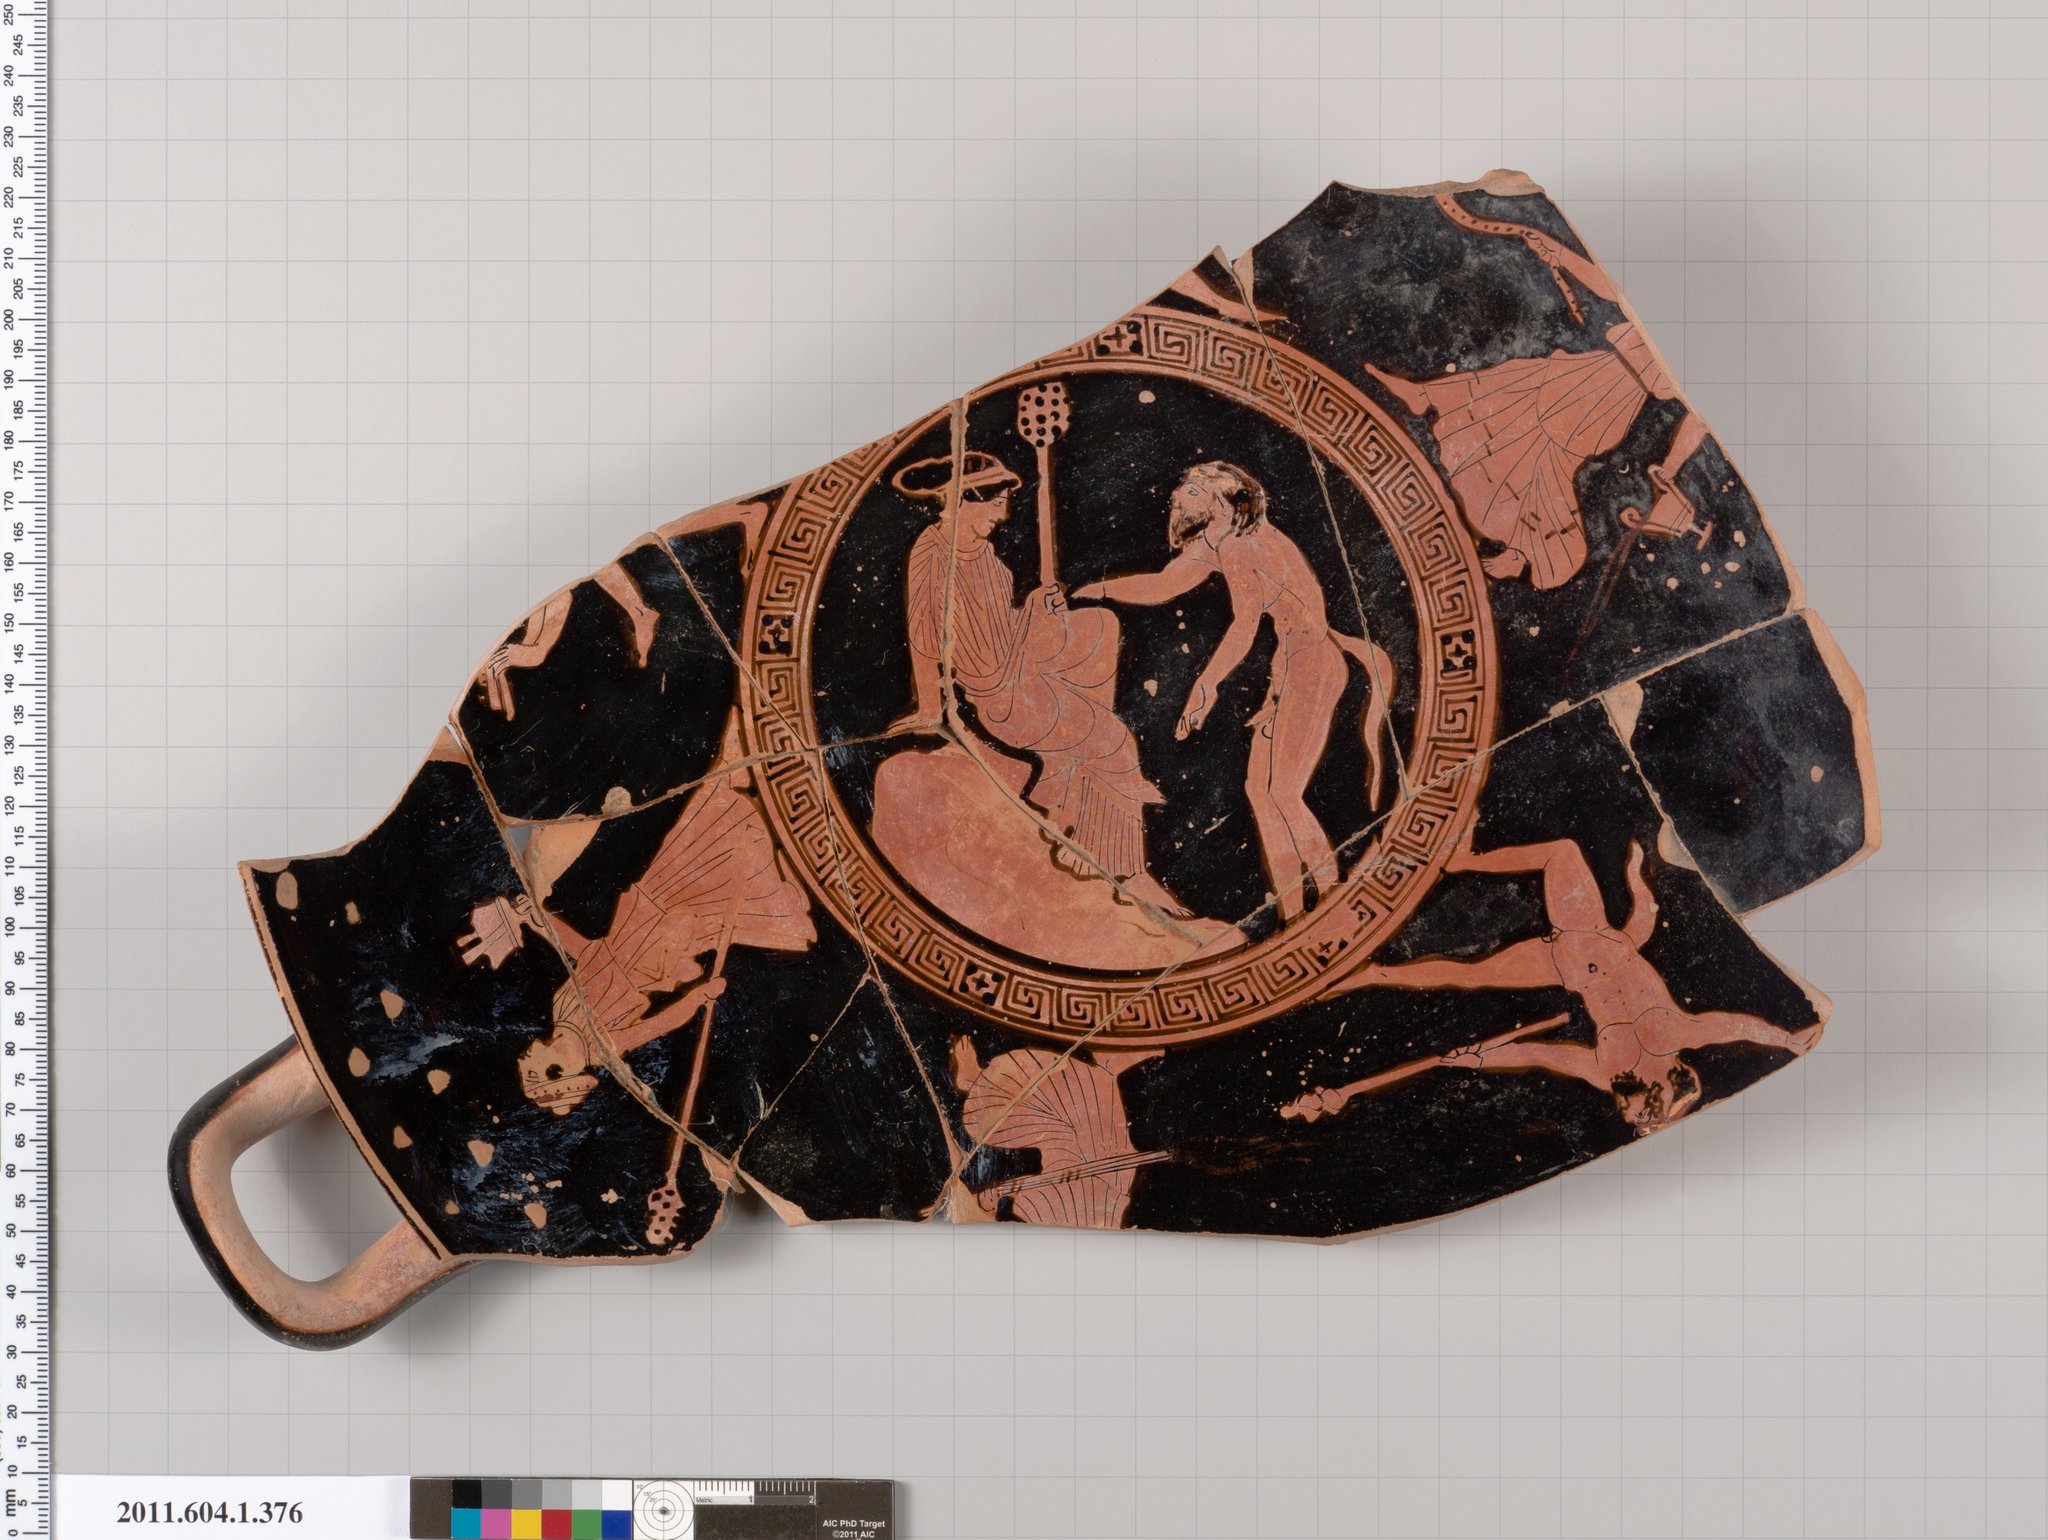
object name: kylix fragment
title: Terracotta fragments of a kylix (drinking cup)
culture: greek, attic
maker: orchard painter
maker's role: artist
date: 467-435 BCE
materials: terracotta